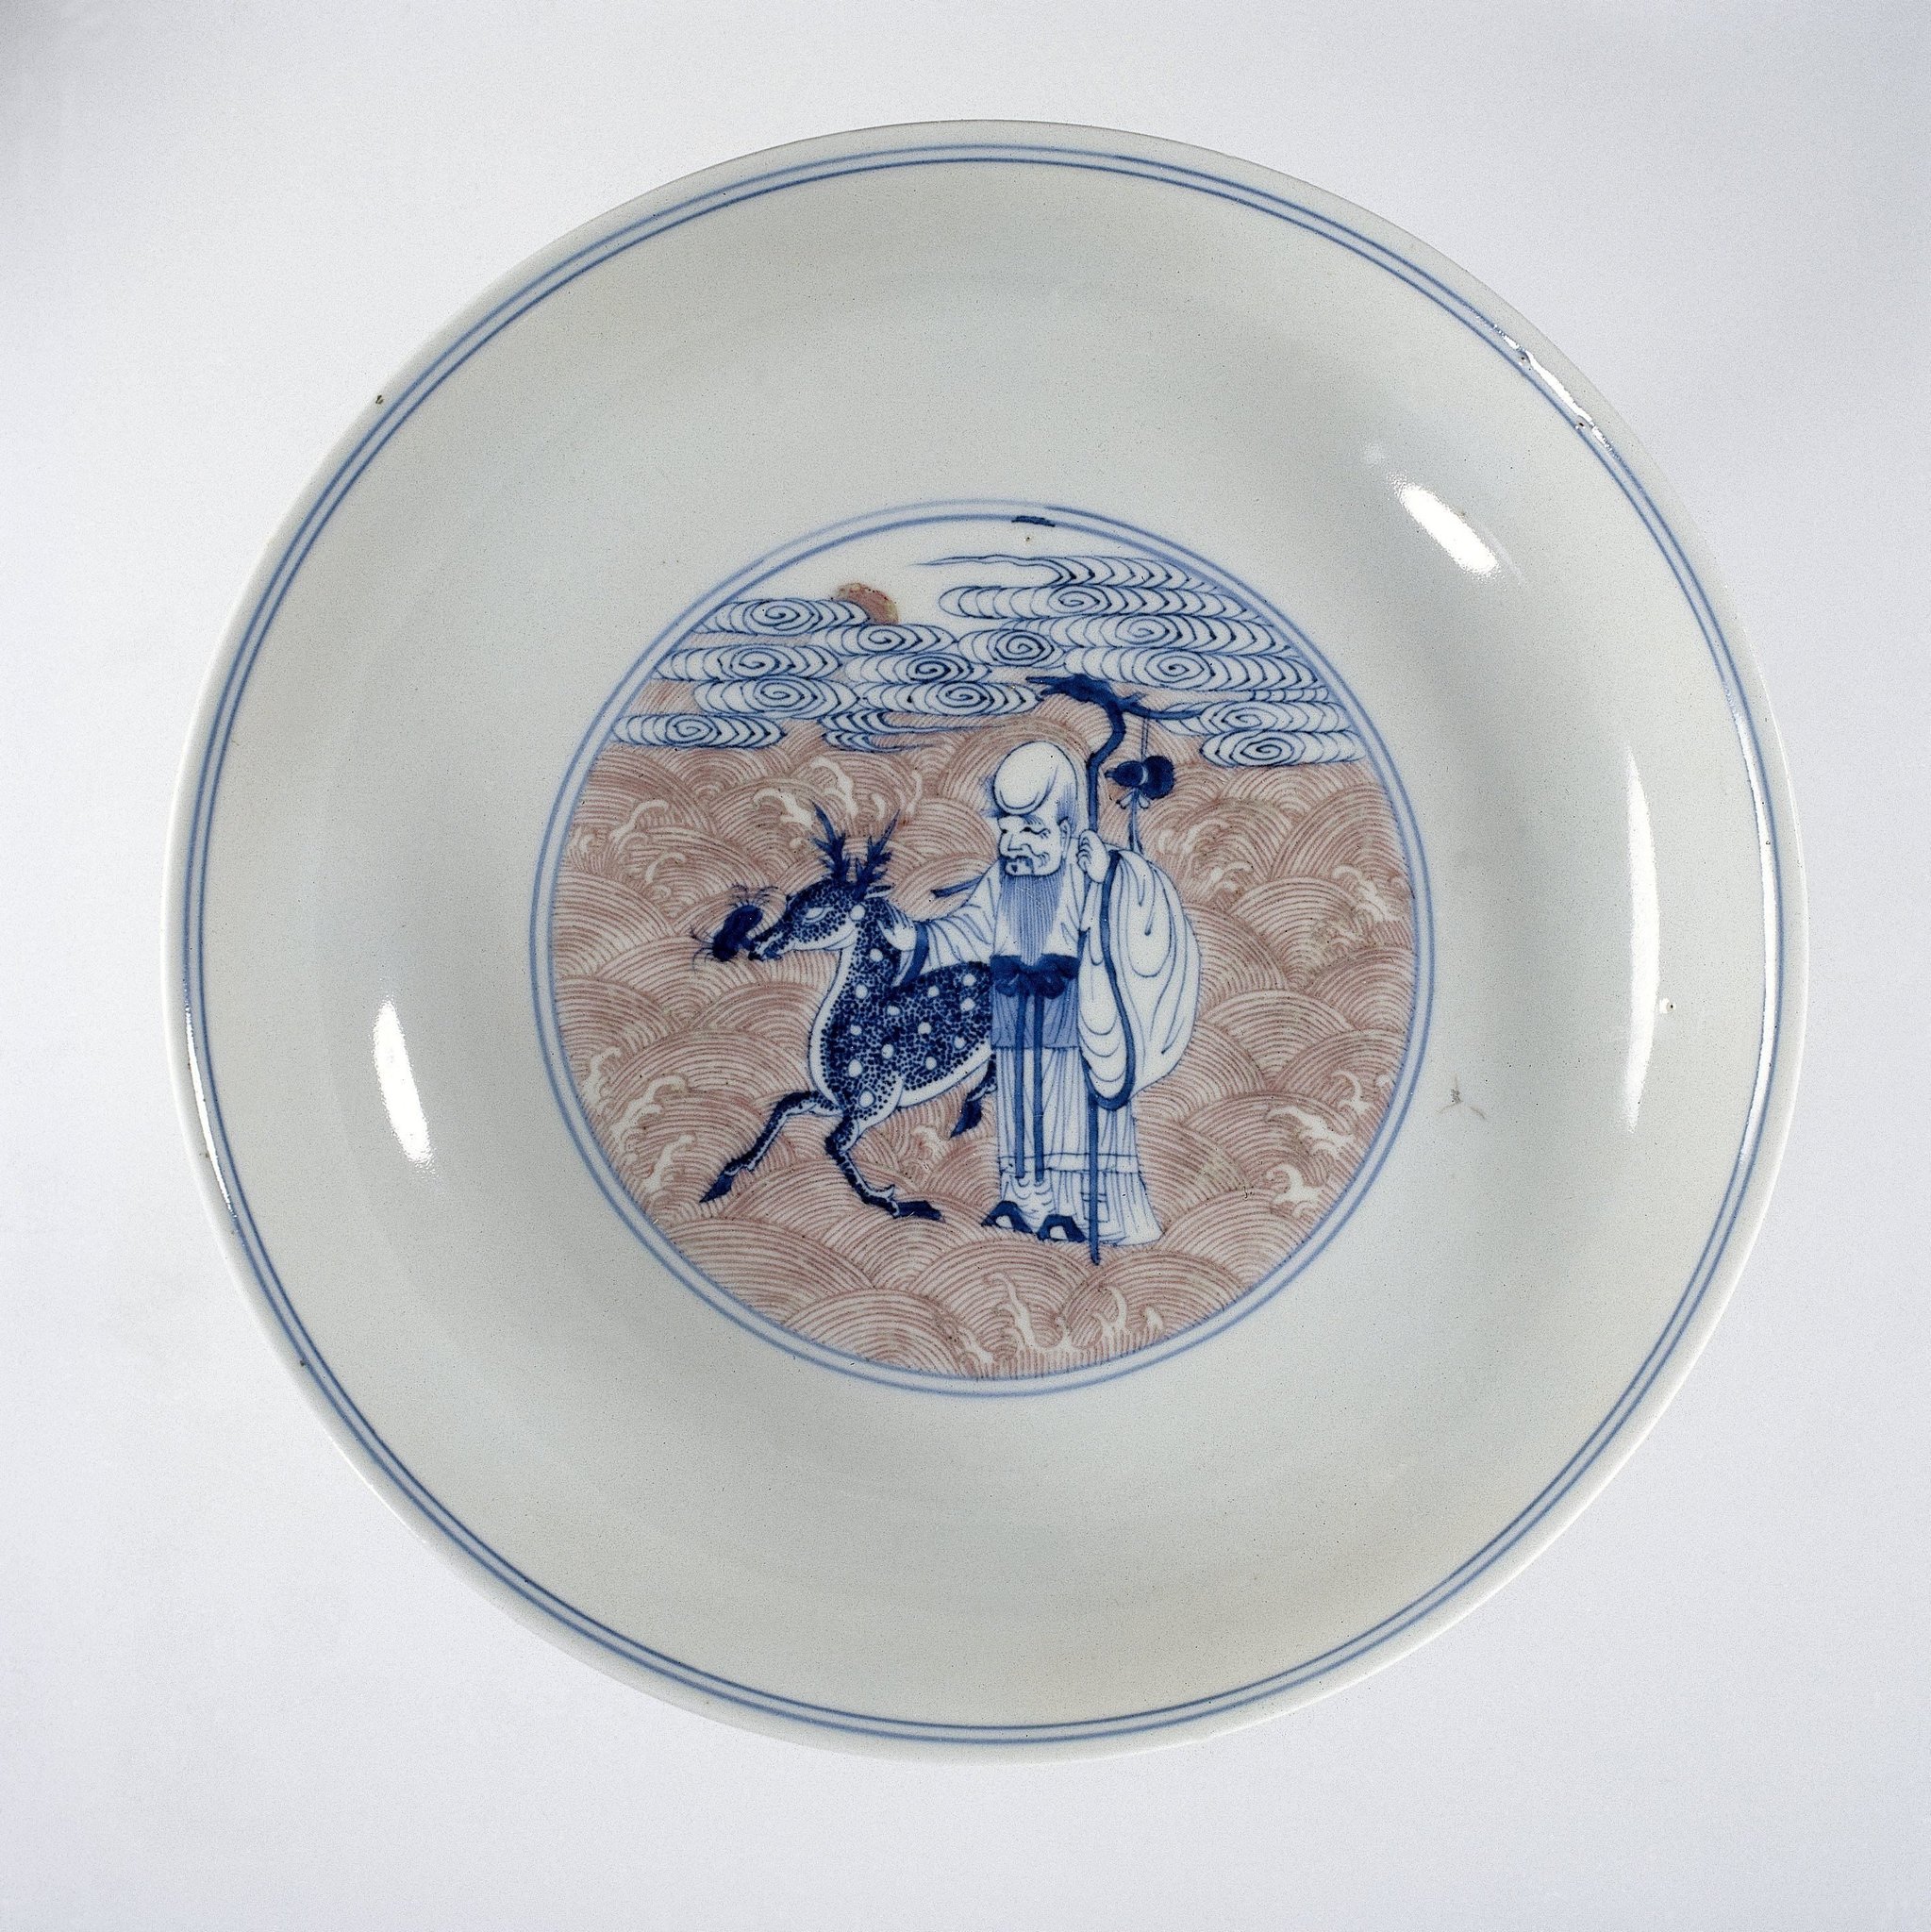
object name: dish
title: Saucer-dish with the Eight Immortals and Shoulao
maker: Anonymous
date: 1800-1824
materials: cobalt, copper, glaze, paint, porcelain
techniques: firing, turning, vitrification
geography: china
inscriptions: mark: ‘Yang he tang zhi’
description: Schaal van porselein met ronde wand, beschilderd in onderglazuur blauw en rood. Op het plat Shoulao met staf en naast hem een hert met paddenstoel in zijn bek tegen een achtergrond van golven en wolken; de buitenwand met de Acht Onsterfelijken tegen een grond van golven. Gemerkt op de bodem met een vier-karakter zegelmerk met 'Hall for cultivating harmony'. Onderglazuur blauw en rood.